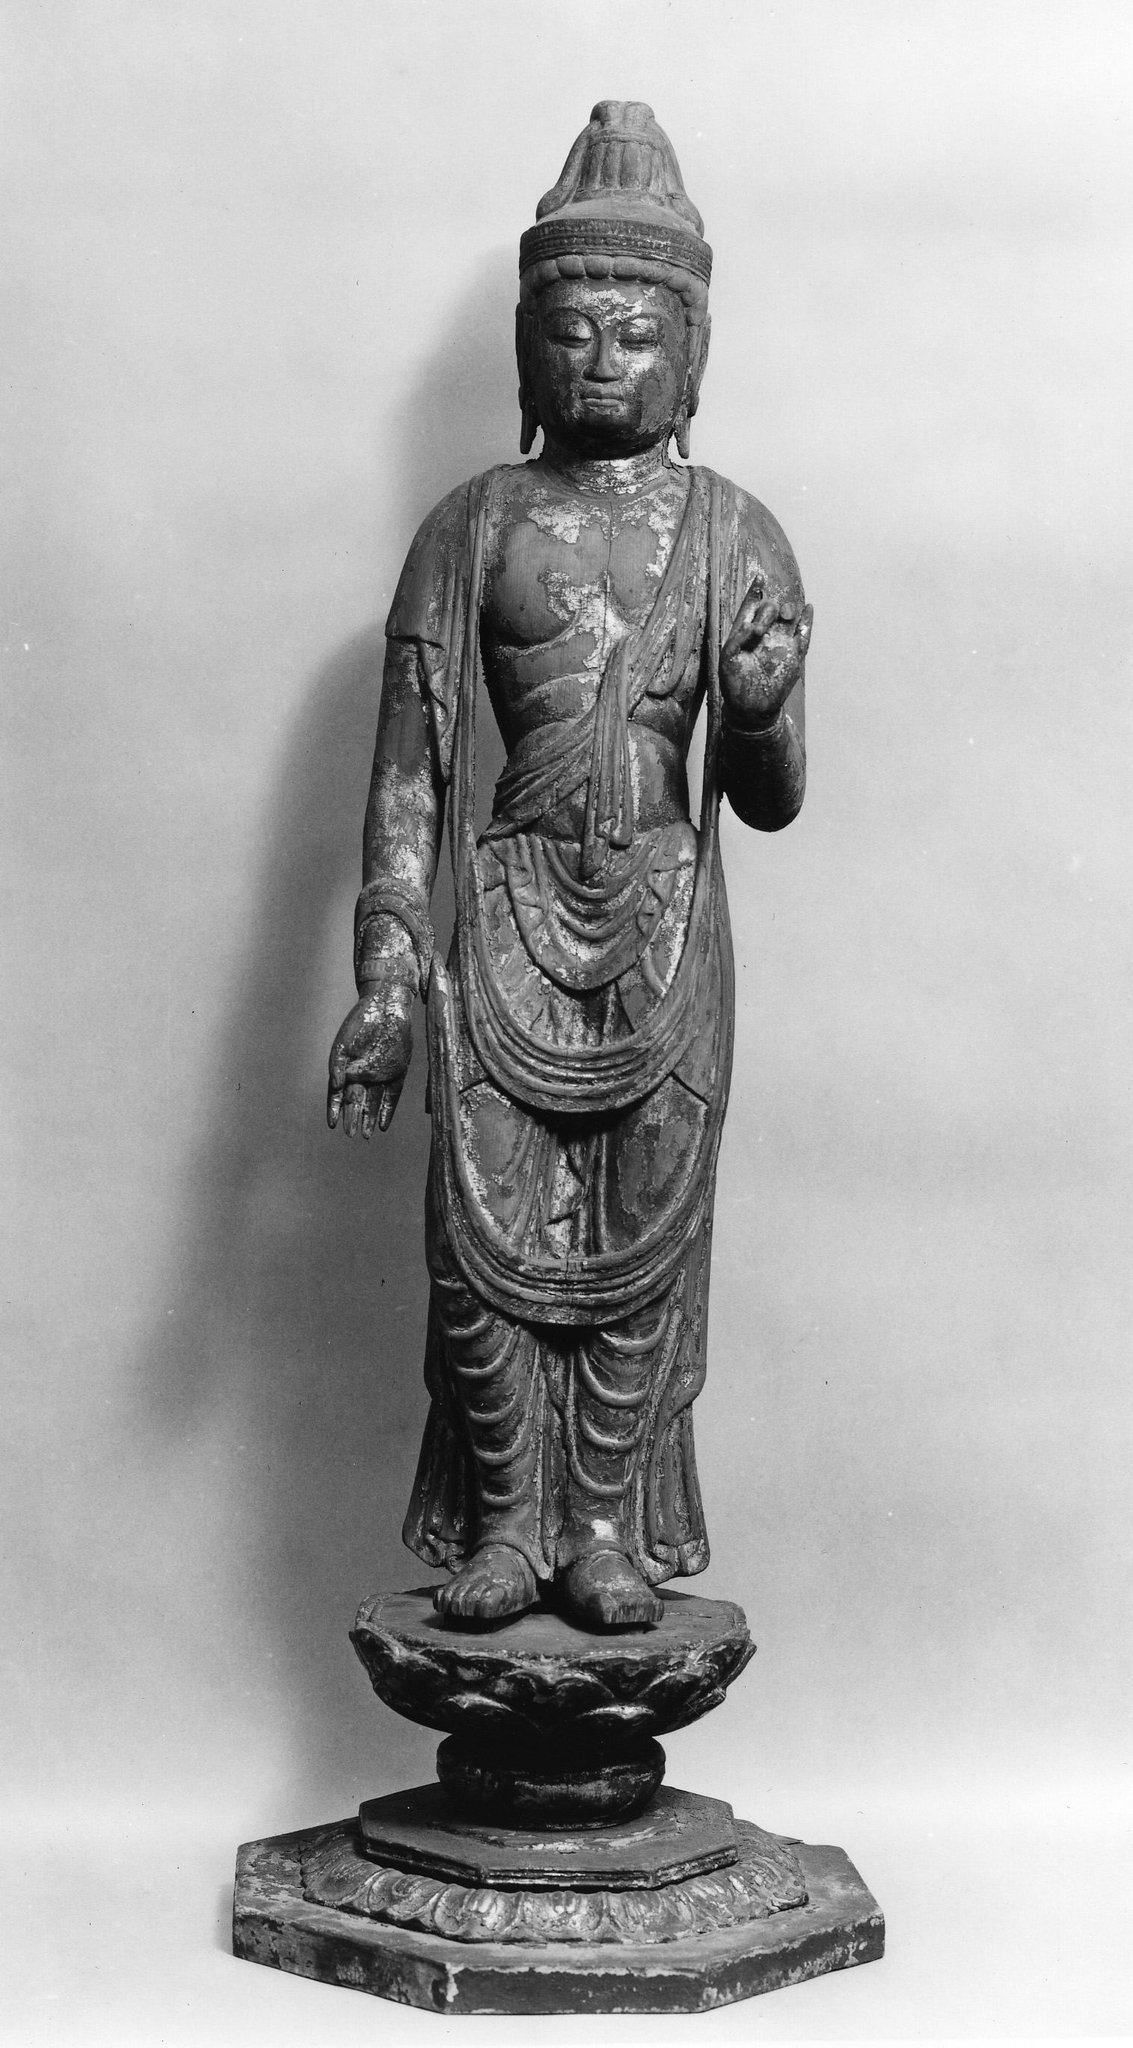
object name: statuette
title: Kannon Bosatsu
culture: japanese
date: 1001-1100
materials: gilt, wood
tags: bodhisattvas